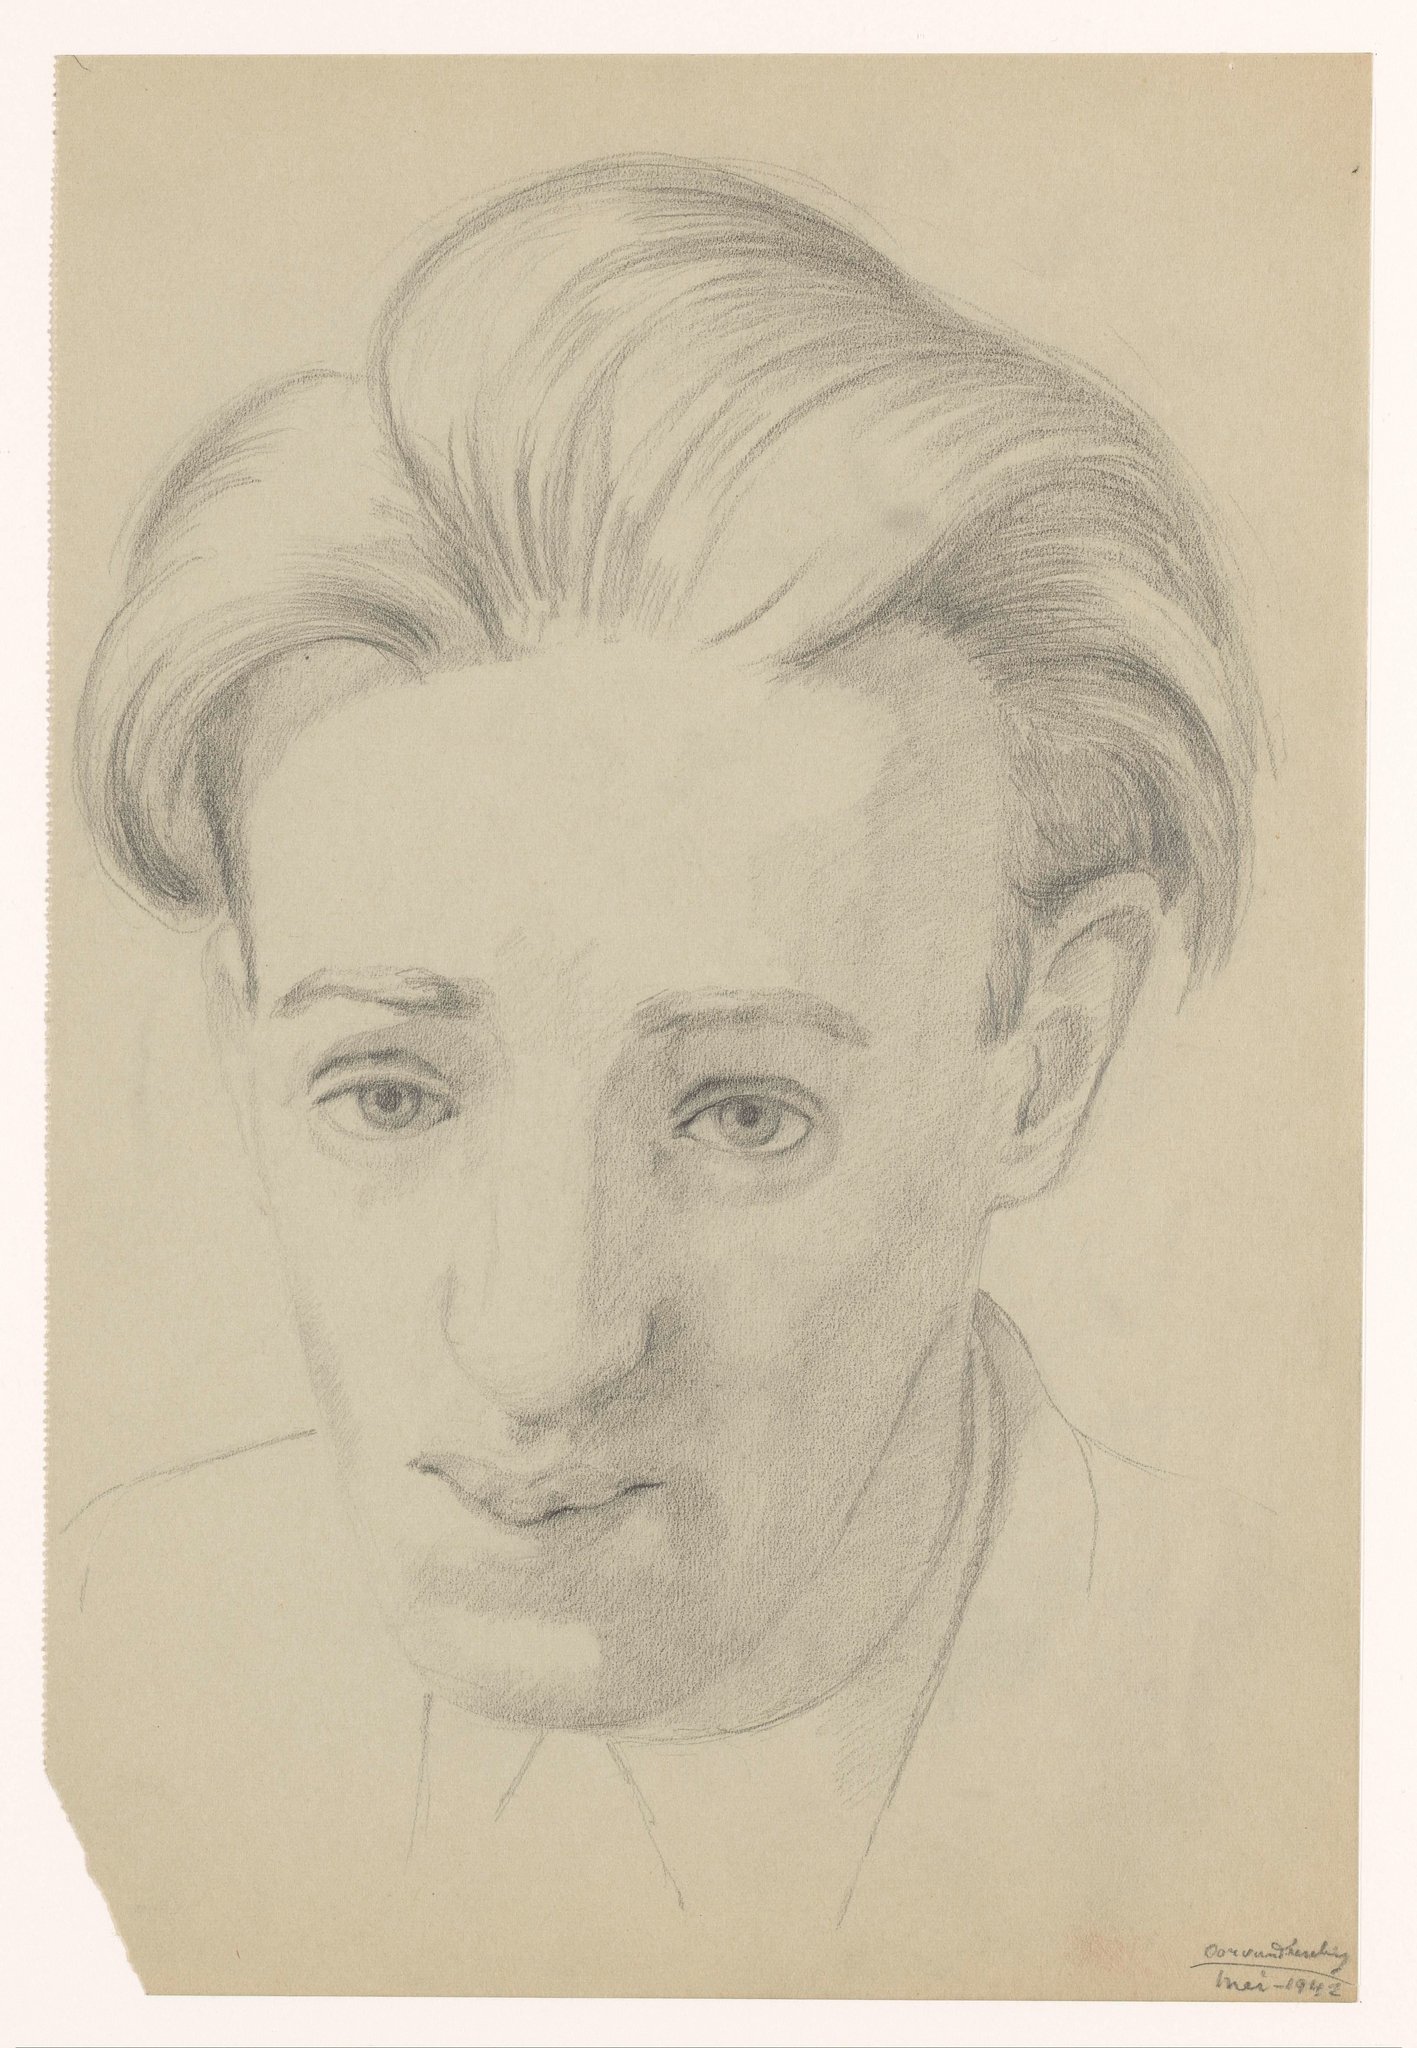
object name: drawing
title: Zelfportret en face, mei 1942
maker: cor van teeseling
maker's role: draughtsman, sculptor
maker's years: 1915-1942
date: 1905-1942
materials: paper, pencil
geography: amsterdam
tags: amsterdam, draughtsman, sculptor, cor van teeseling, historical persons, prisoner in cell or locked place, portrait, self-portrait of draughtsman, netherlands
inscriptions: inscription: ‘dag Eddy’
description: Zelfportret van Cor van Teeseling en face, mei 1942.